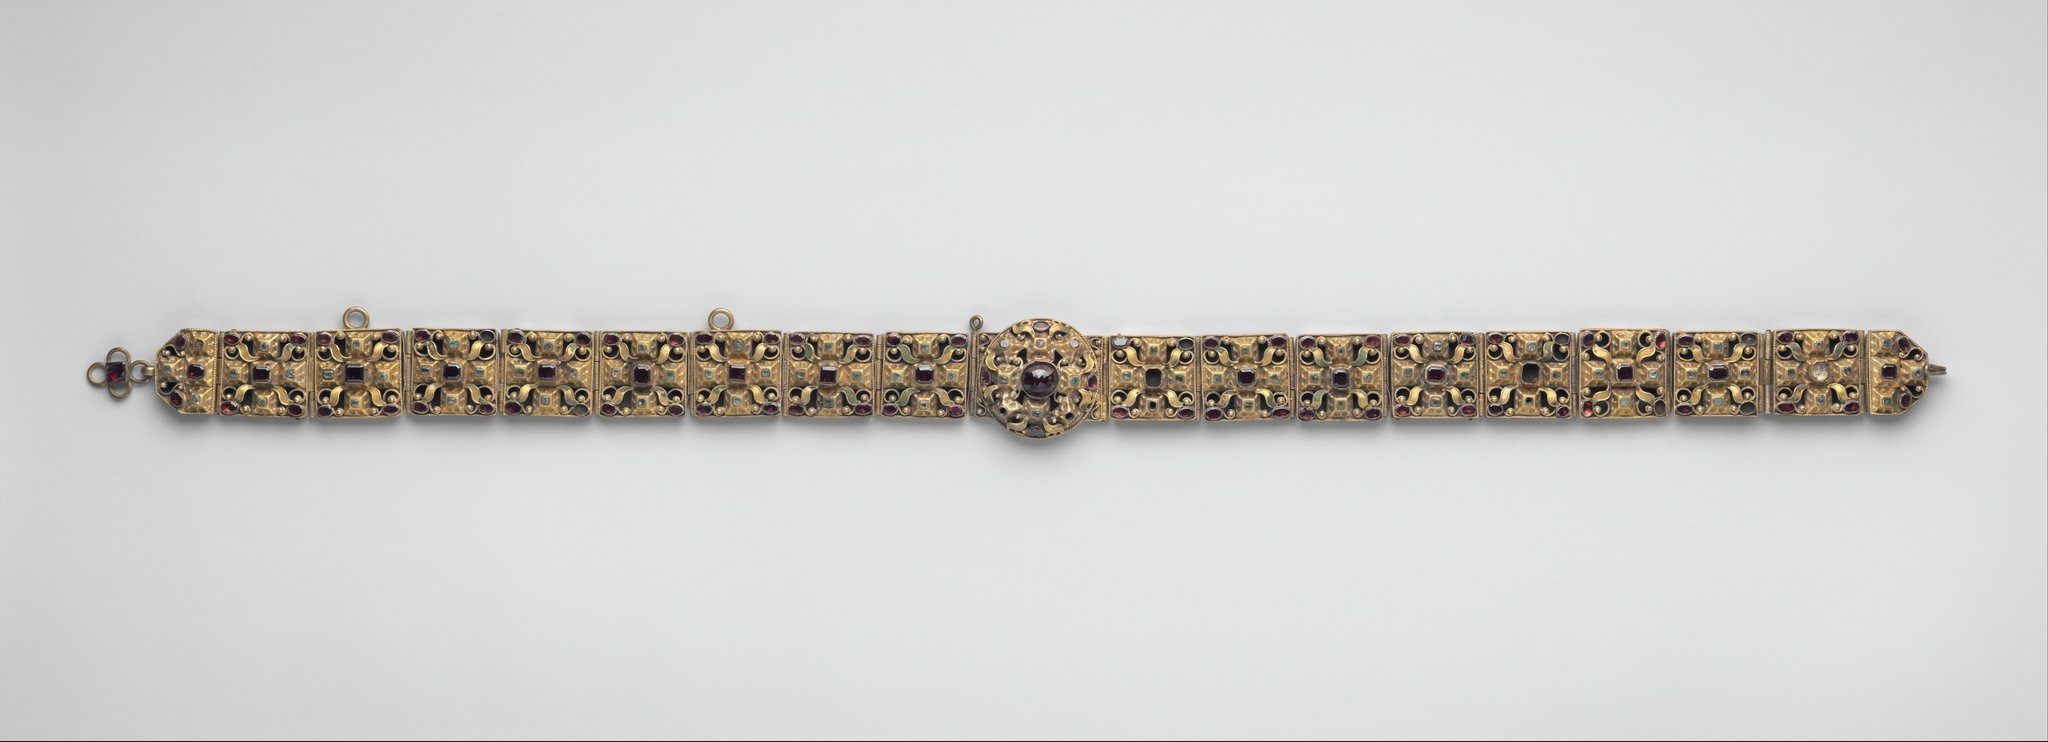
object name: belt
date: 1700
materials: garnet, gilt silver